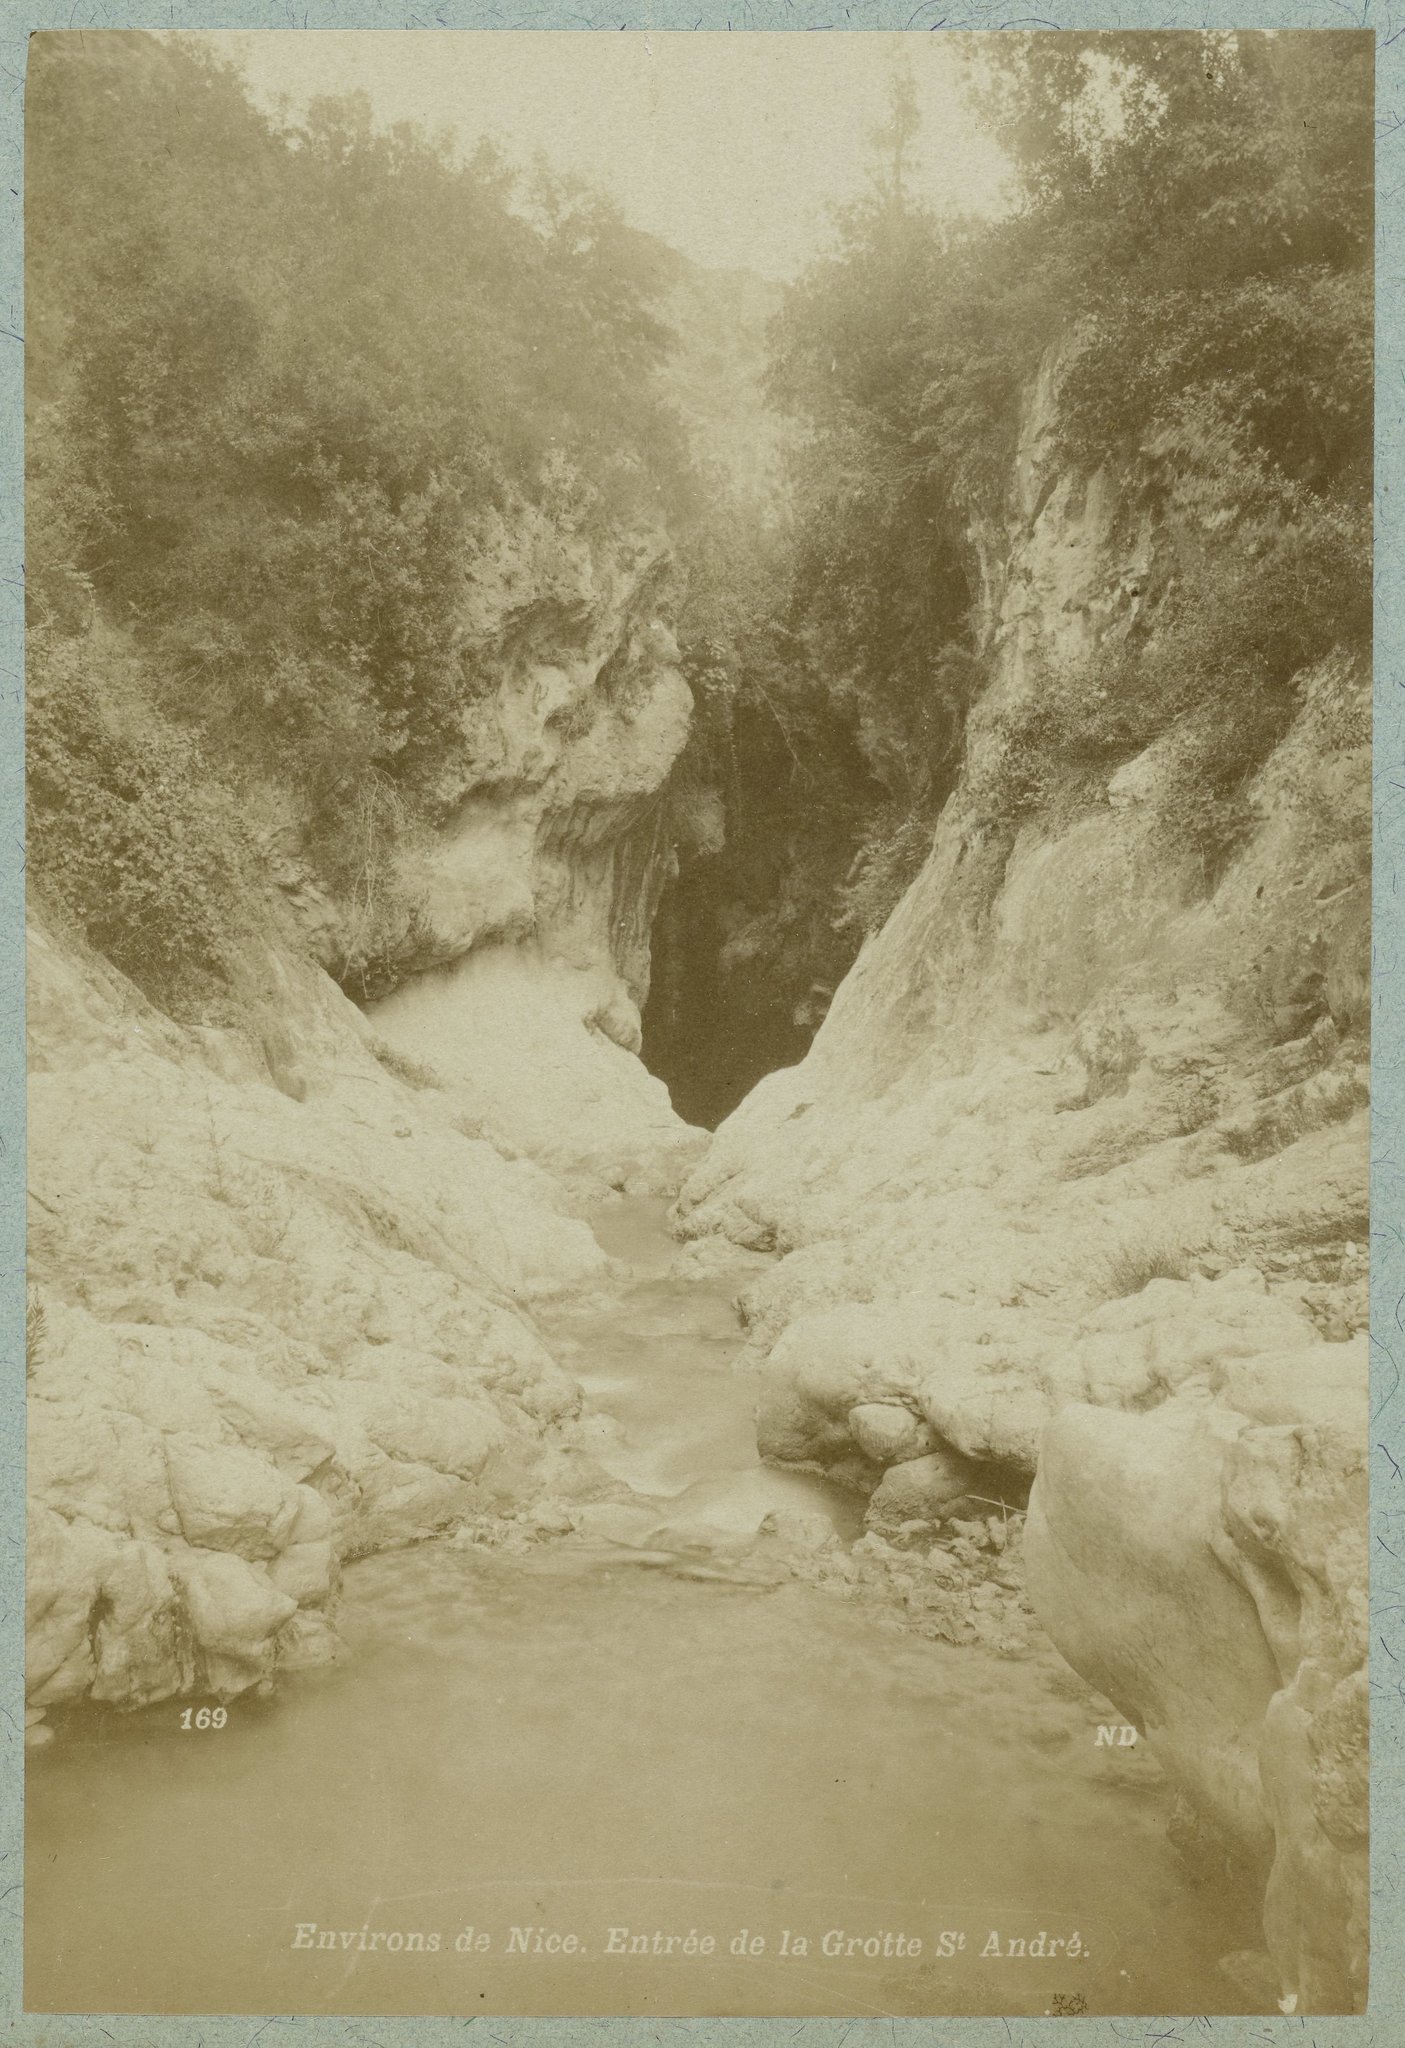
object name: photograph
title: Environs de Nice. Entrée de la Grotte St André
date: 1863-1891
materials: cardboard, paper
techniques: albumen print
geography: nice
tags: cave, grotto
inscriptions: inscription: ‘169/ Environs de Nice. Entrée de la Grotte St André./ ND’, collector's mark: ‘Vosmaer’